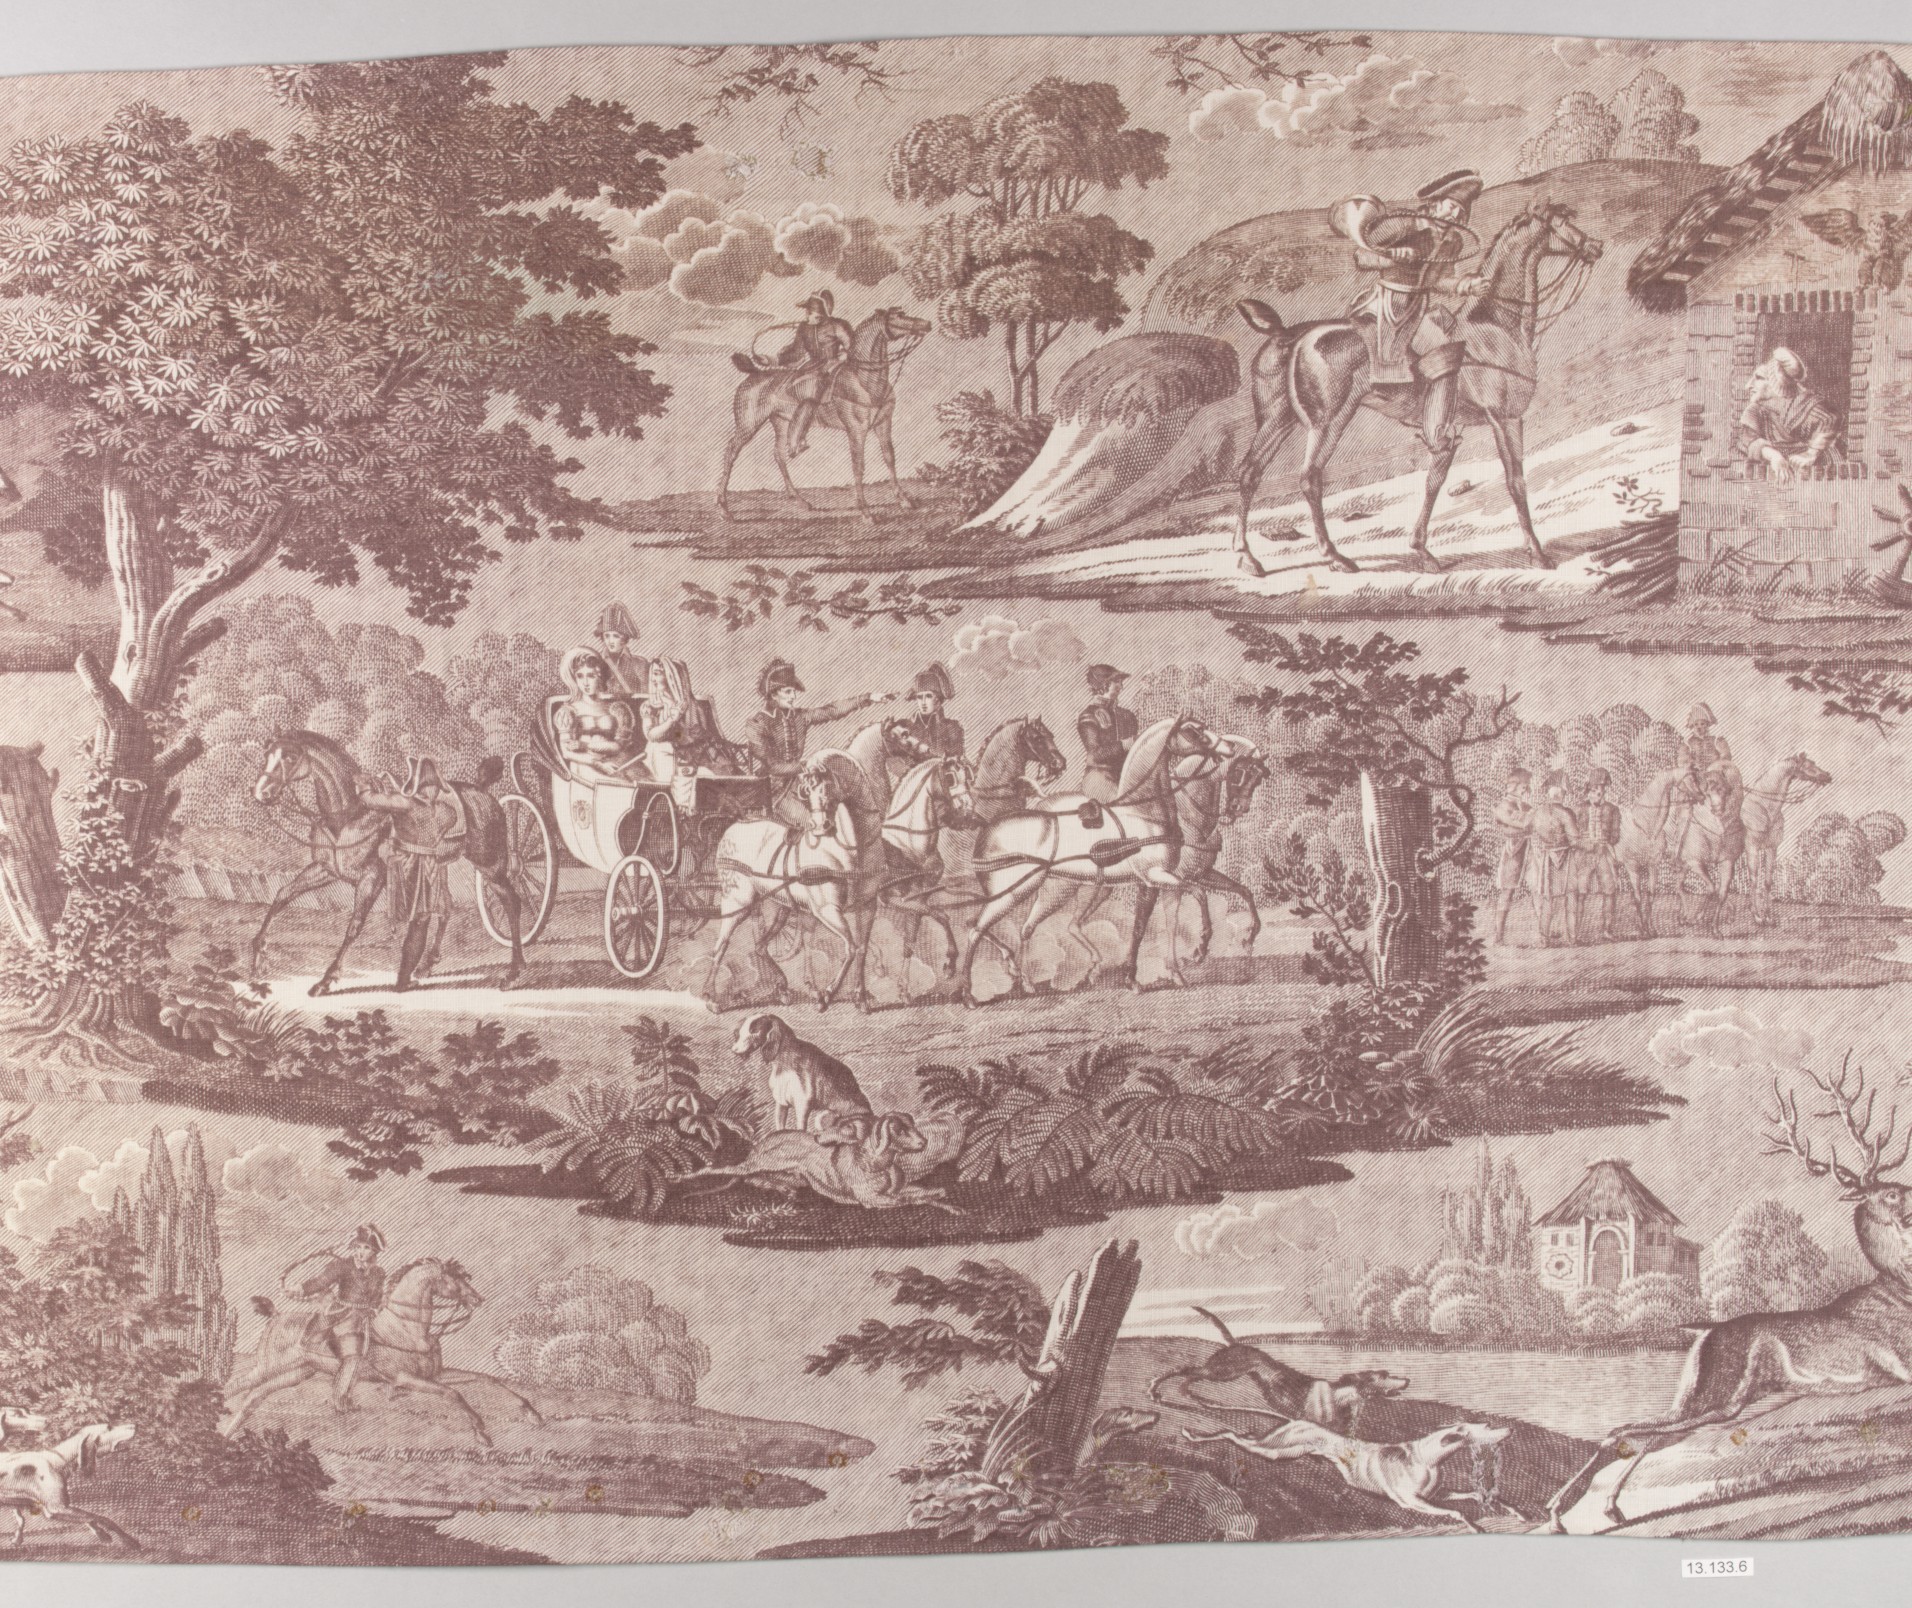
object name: furnishing textile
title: The Chase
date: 1815-1825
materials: cotton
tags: men,women,horses,trees,carriages